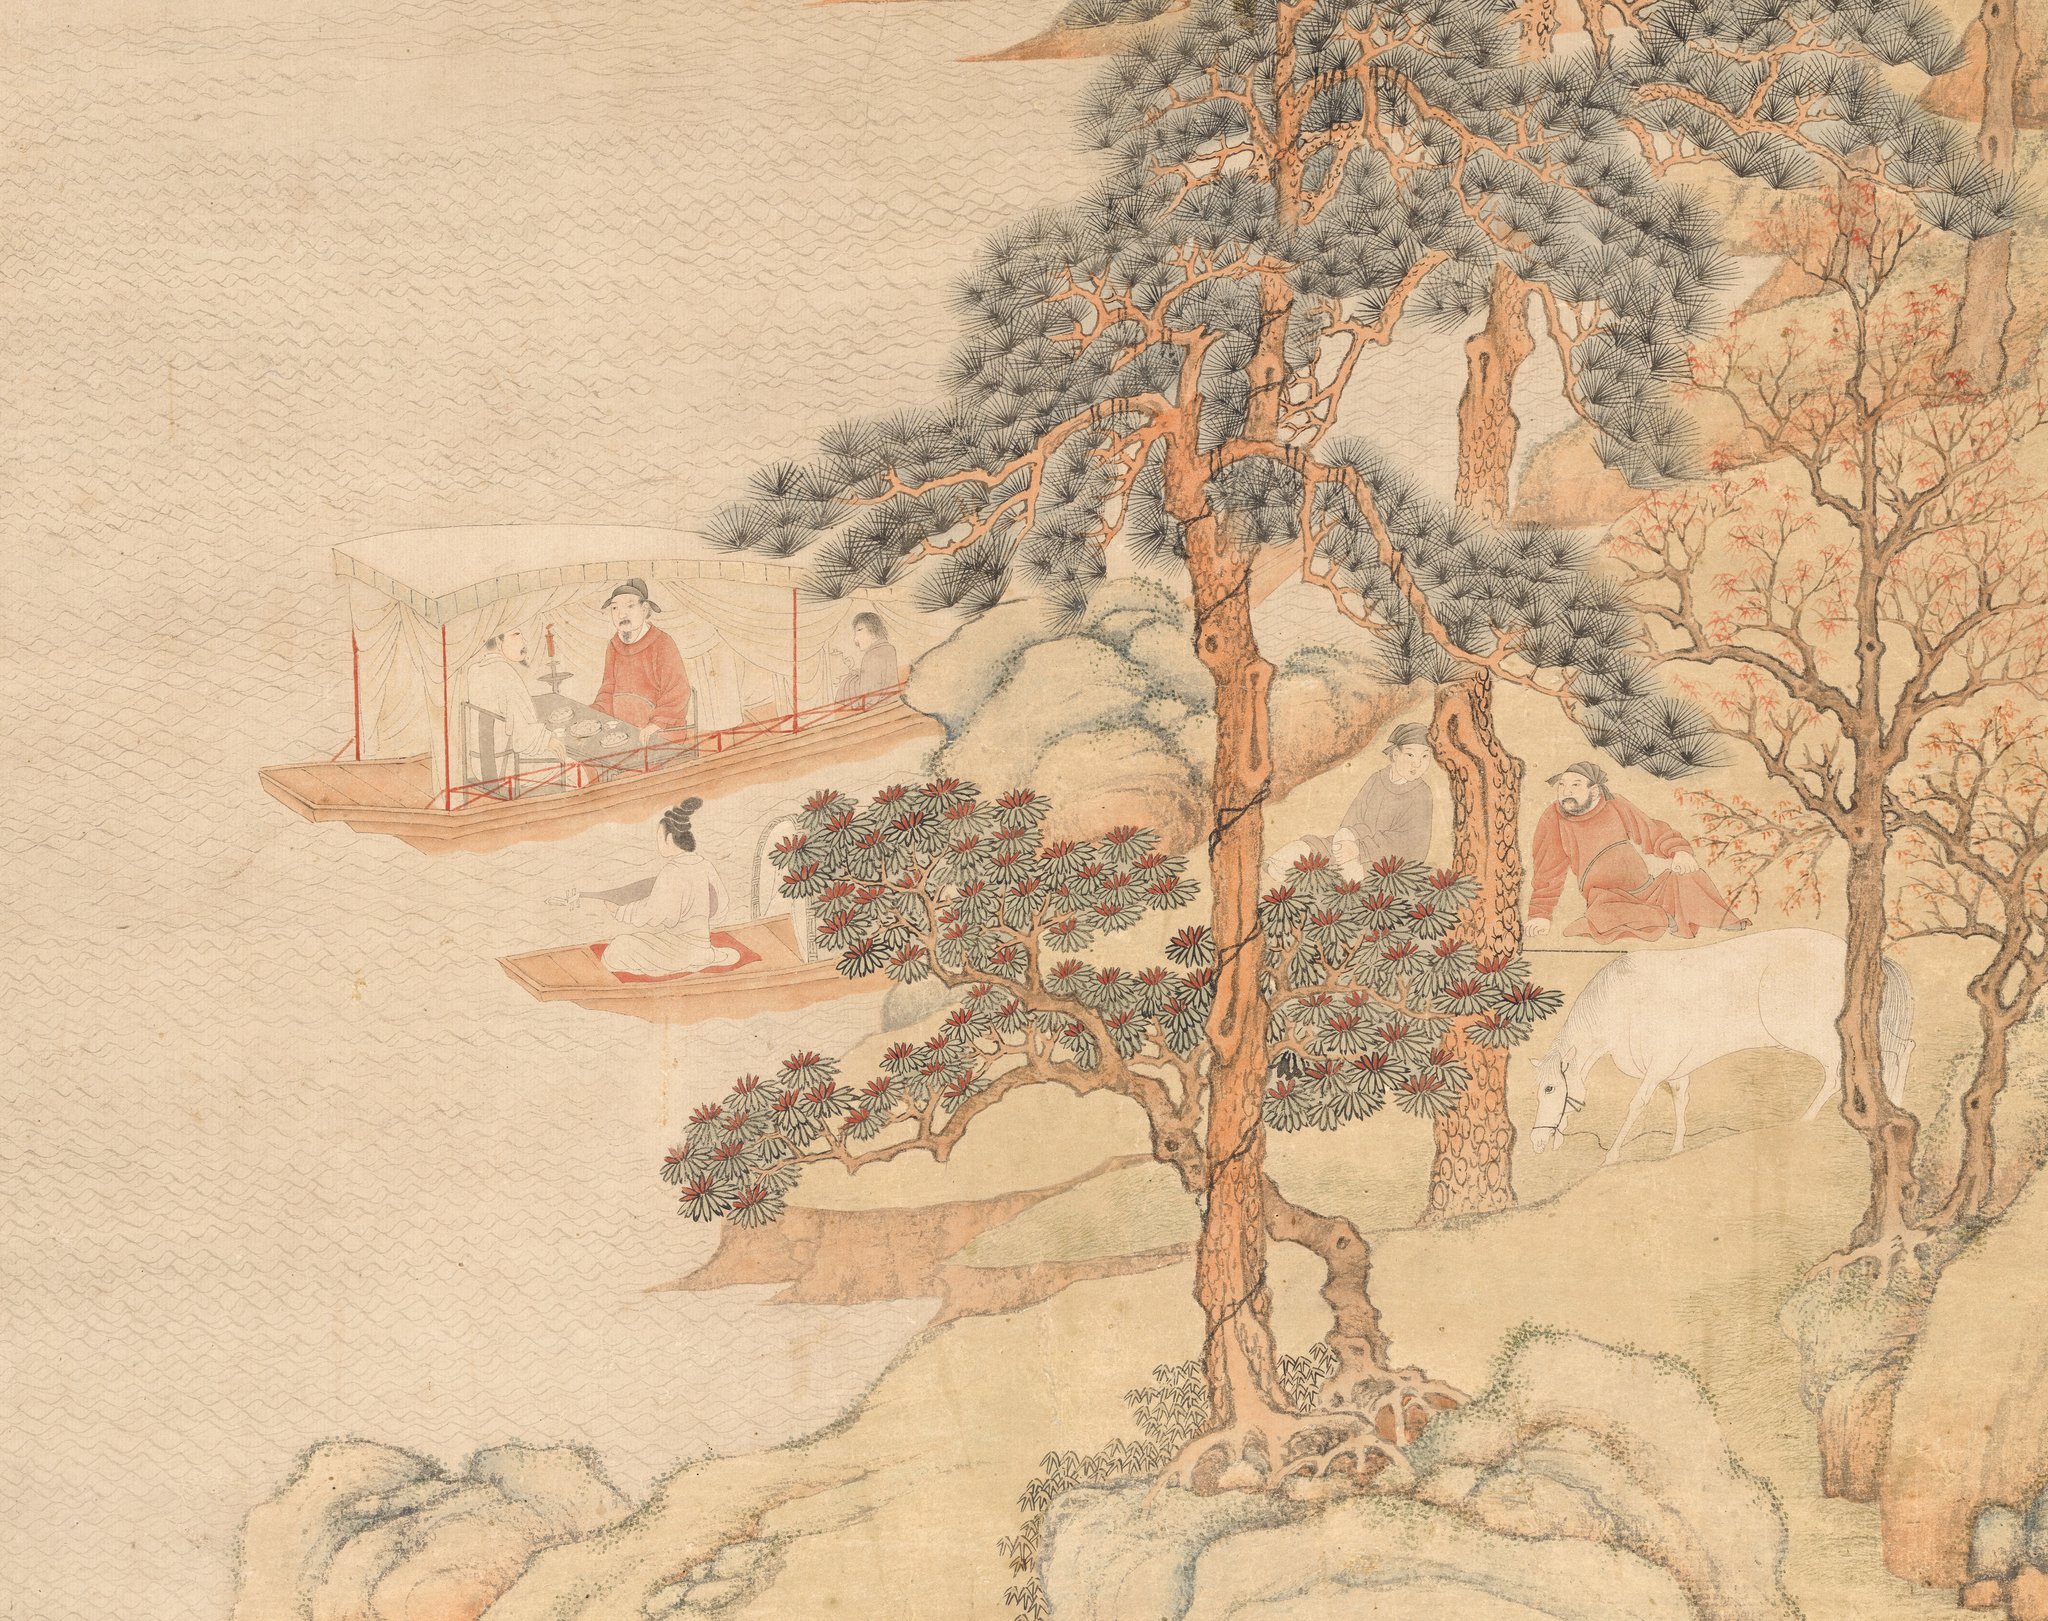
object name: hanging scroll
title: Song of the Lute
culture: chinese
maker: ding yunpeng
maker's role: artist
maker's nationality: chinese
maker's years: 1547-1621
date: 1585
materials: ink, paper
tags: mountains,trees,boats